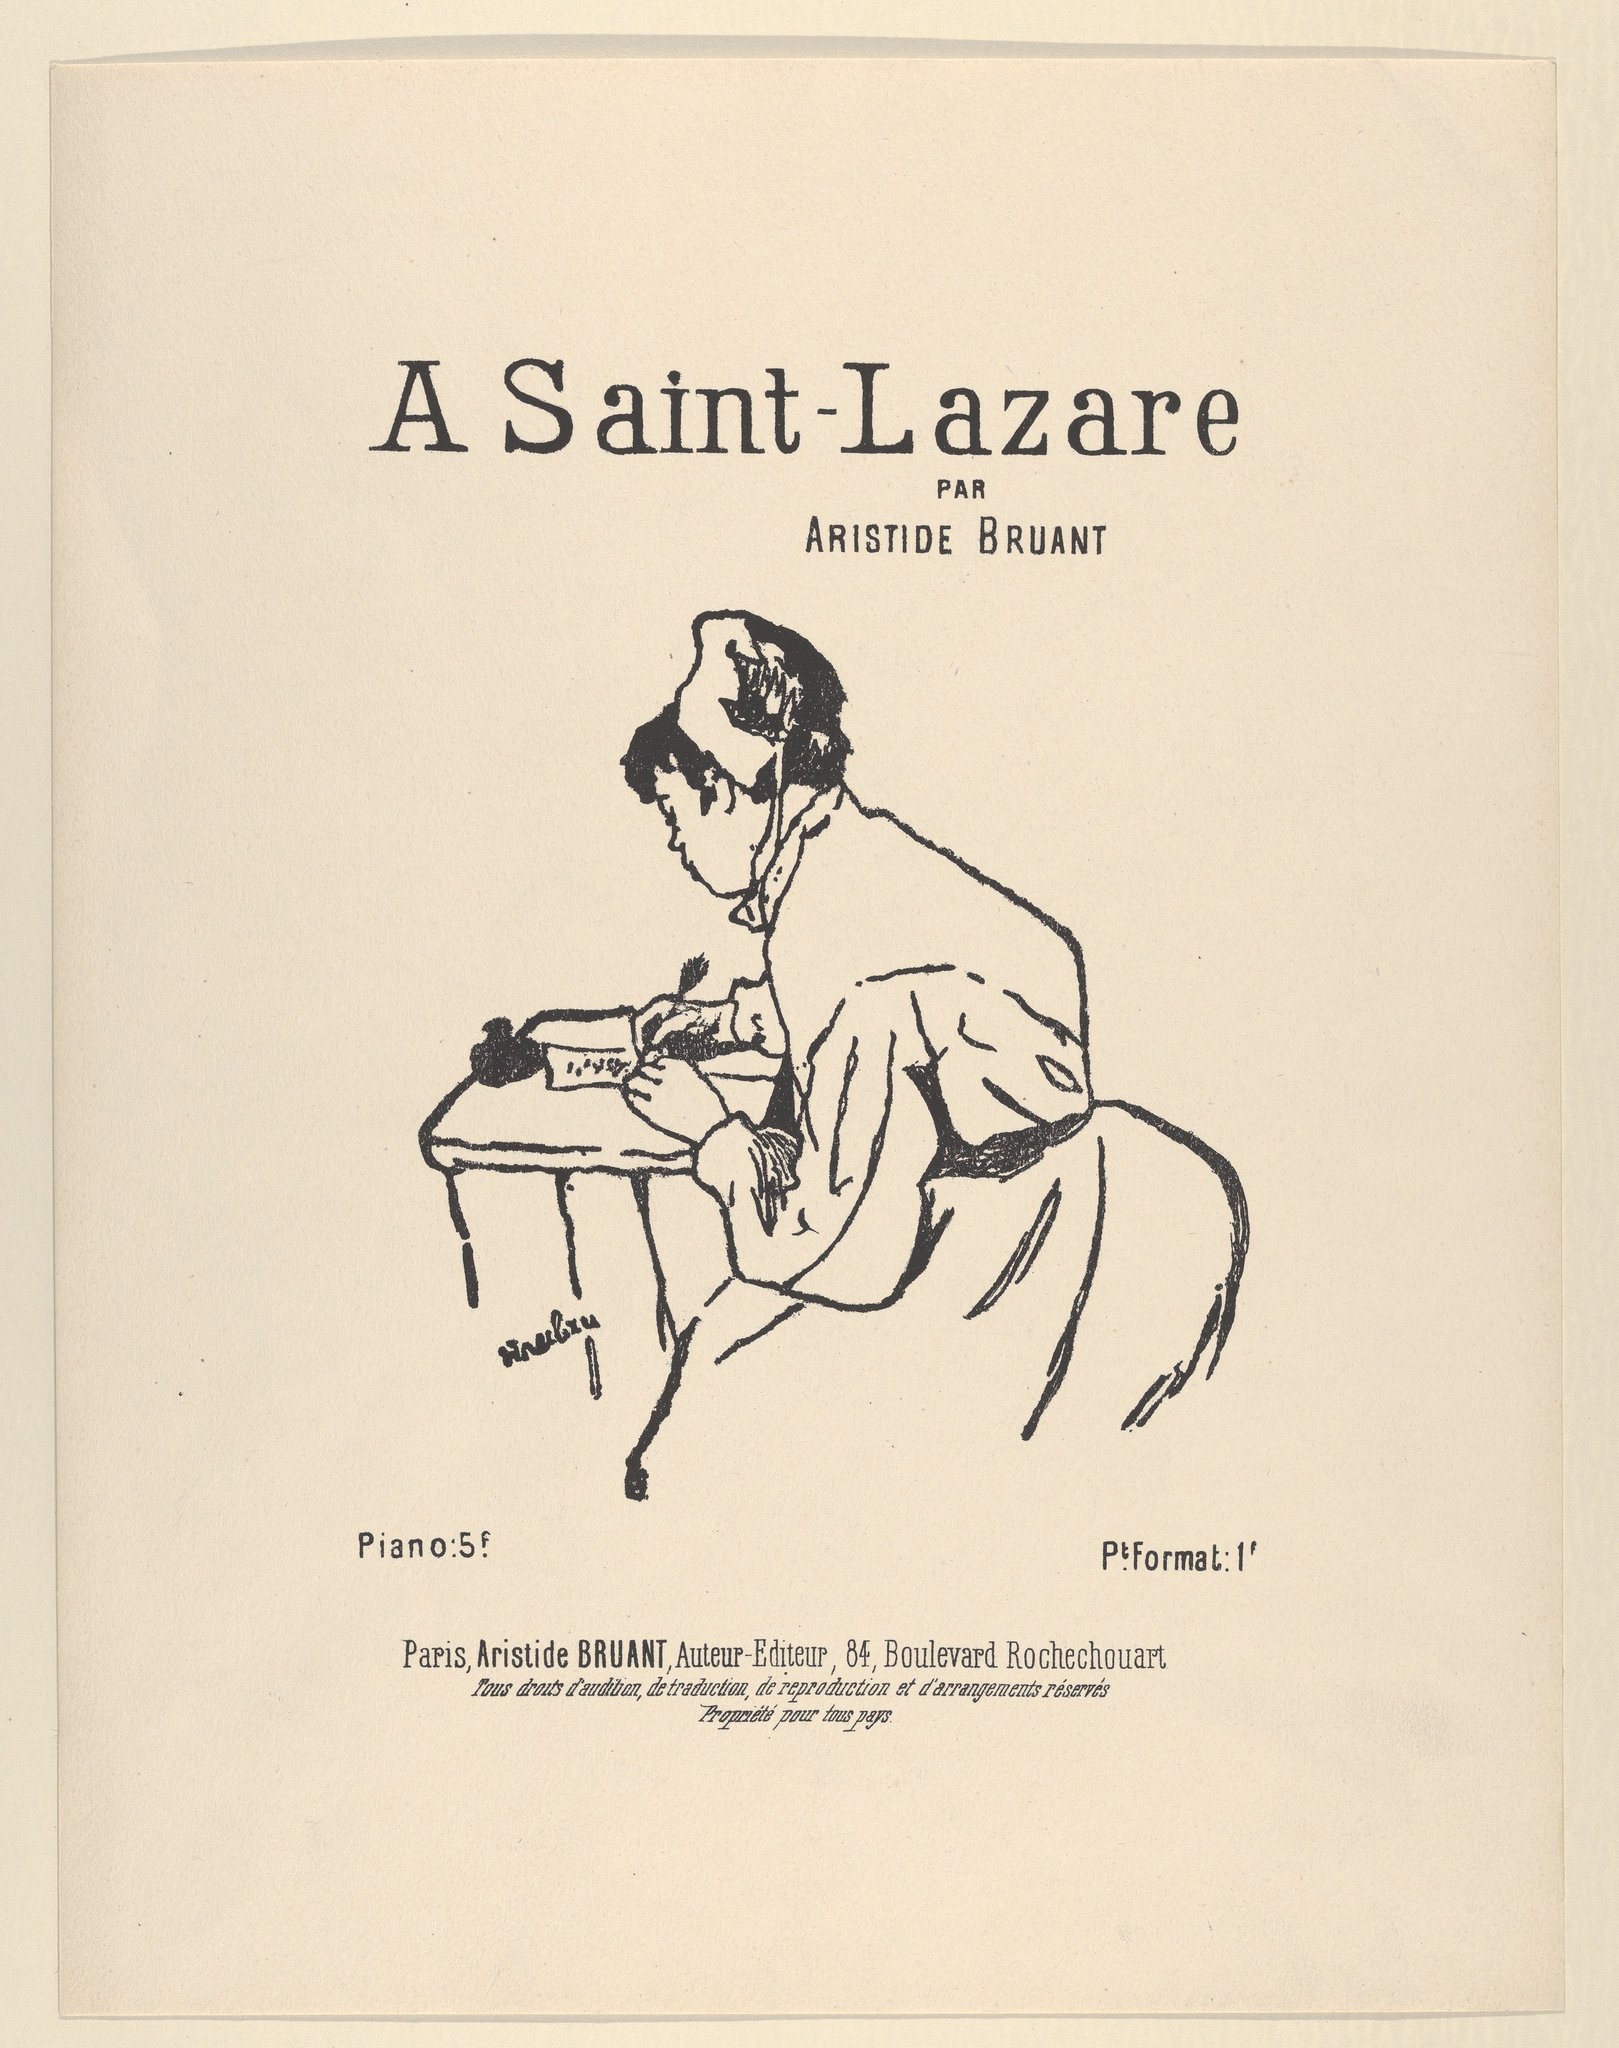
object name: print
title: A Saint-Lazare par Aristide Bruant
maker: henri de toulouse-lautrec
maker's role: artist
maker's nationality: french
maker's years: 1864-1901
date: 1882-1901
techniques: lithograph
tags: women,writing